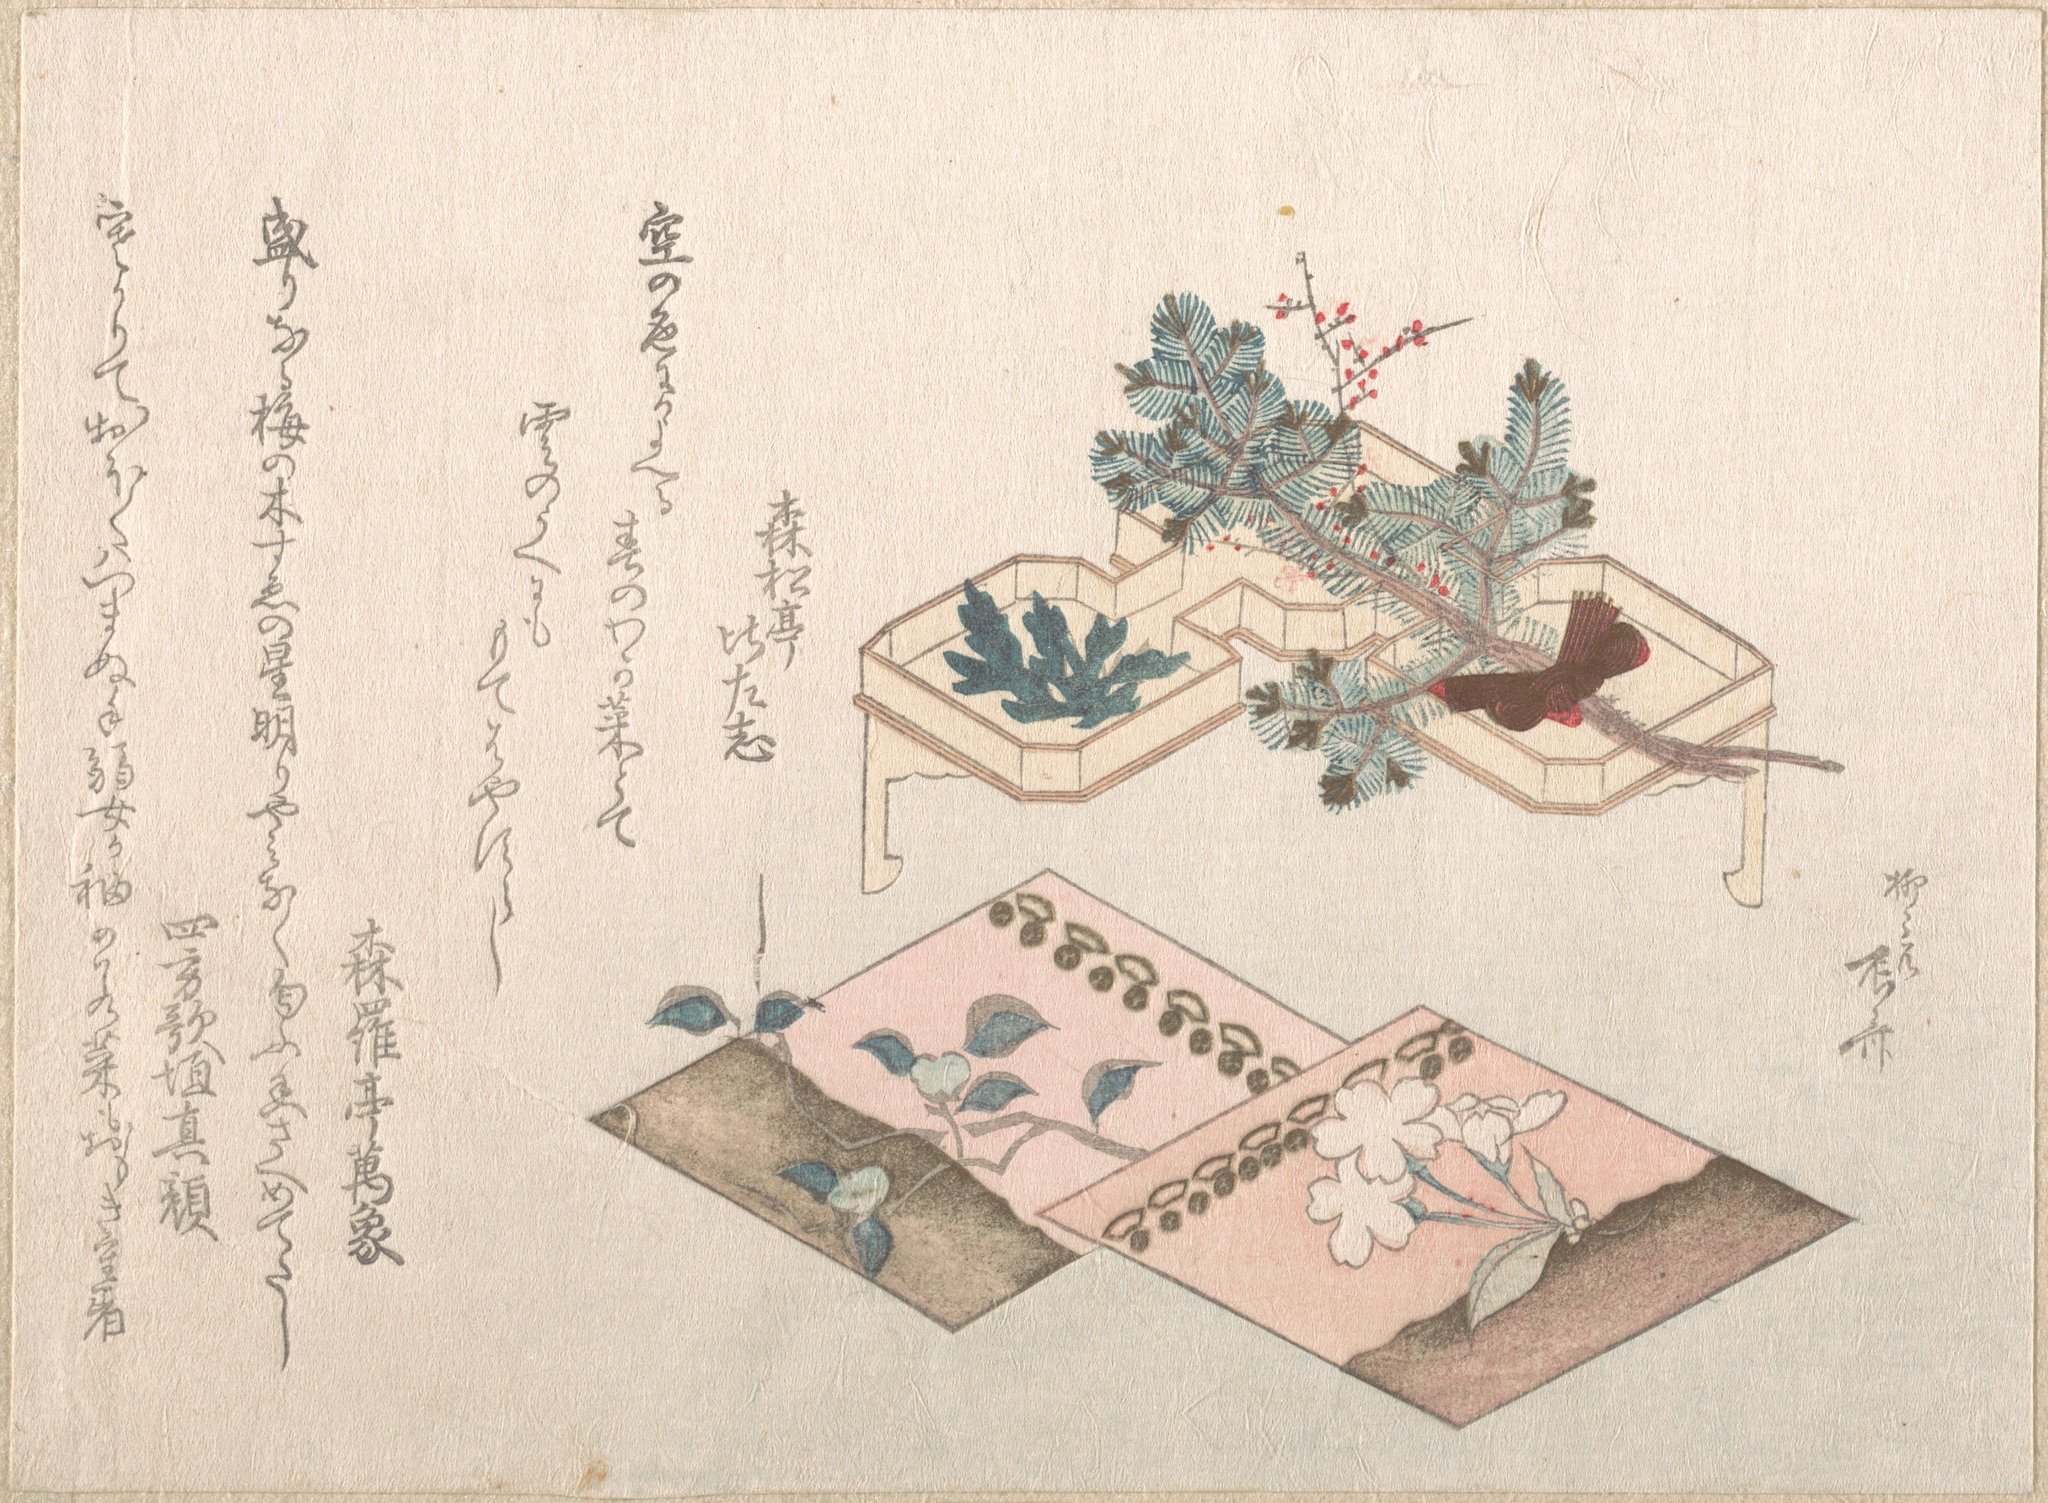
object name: print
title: Spring Rain Collection (Harusame shū), vol. 2: Pine Shoots and Accoutrements for New Year’s Celebrations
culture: japanese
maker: ryūryūkyo shinsai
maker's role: artist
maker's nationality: japanese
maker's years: 1799-1823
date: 1801-1900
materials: ink, paper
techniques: surimono, woodblock print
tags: flowers,leaves